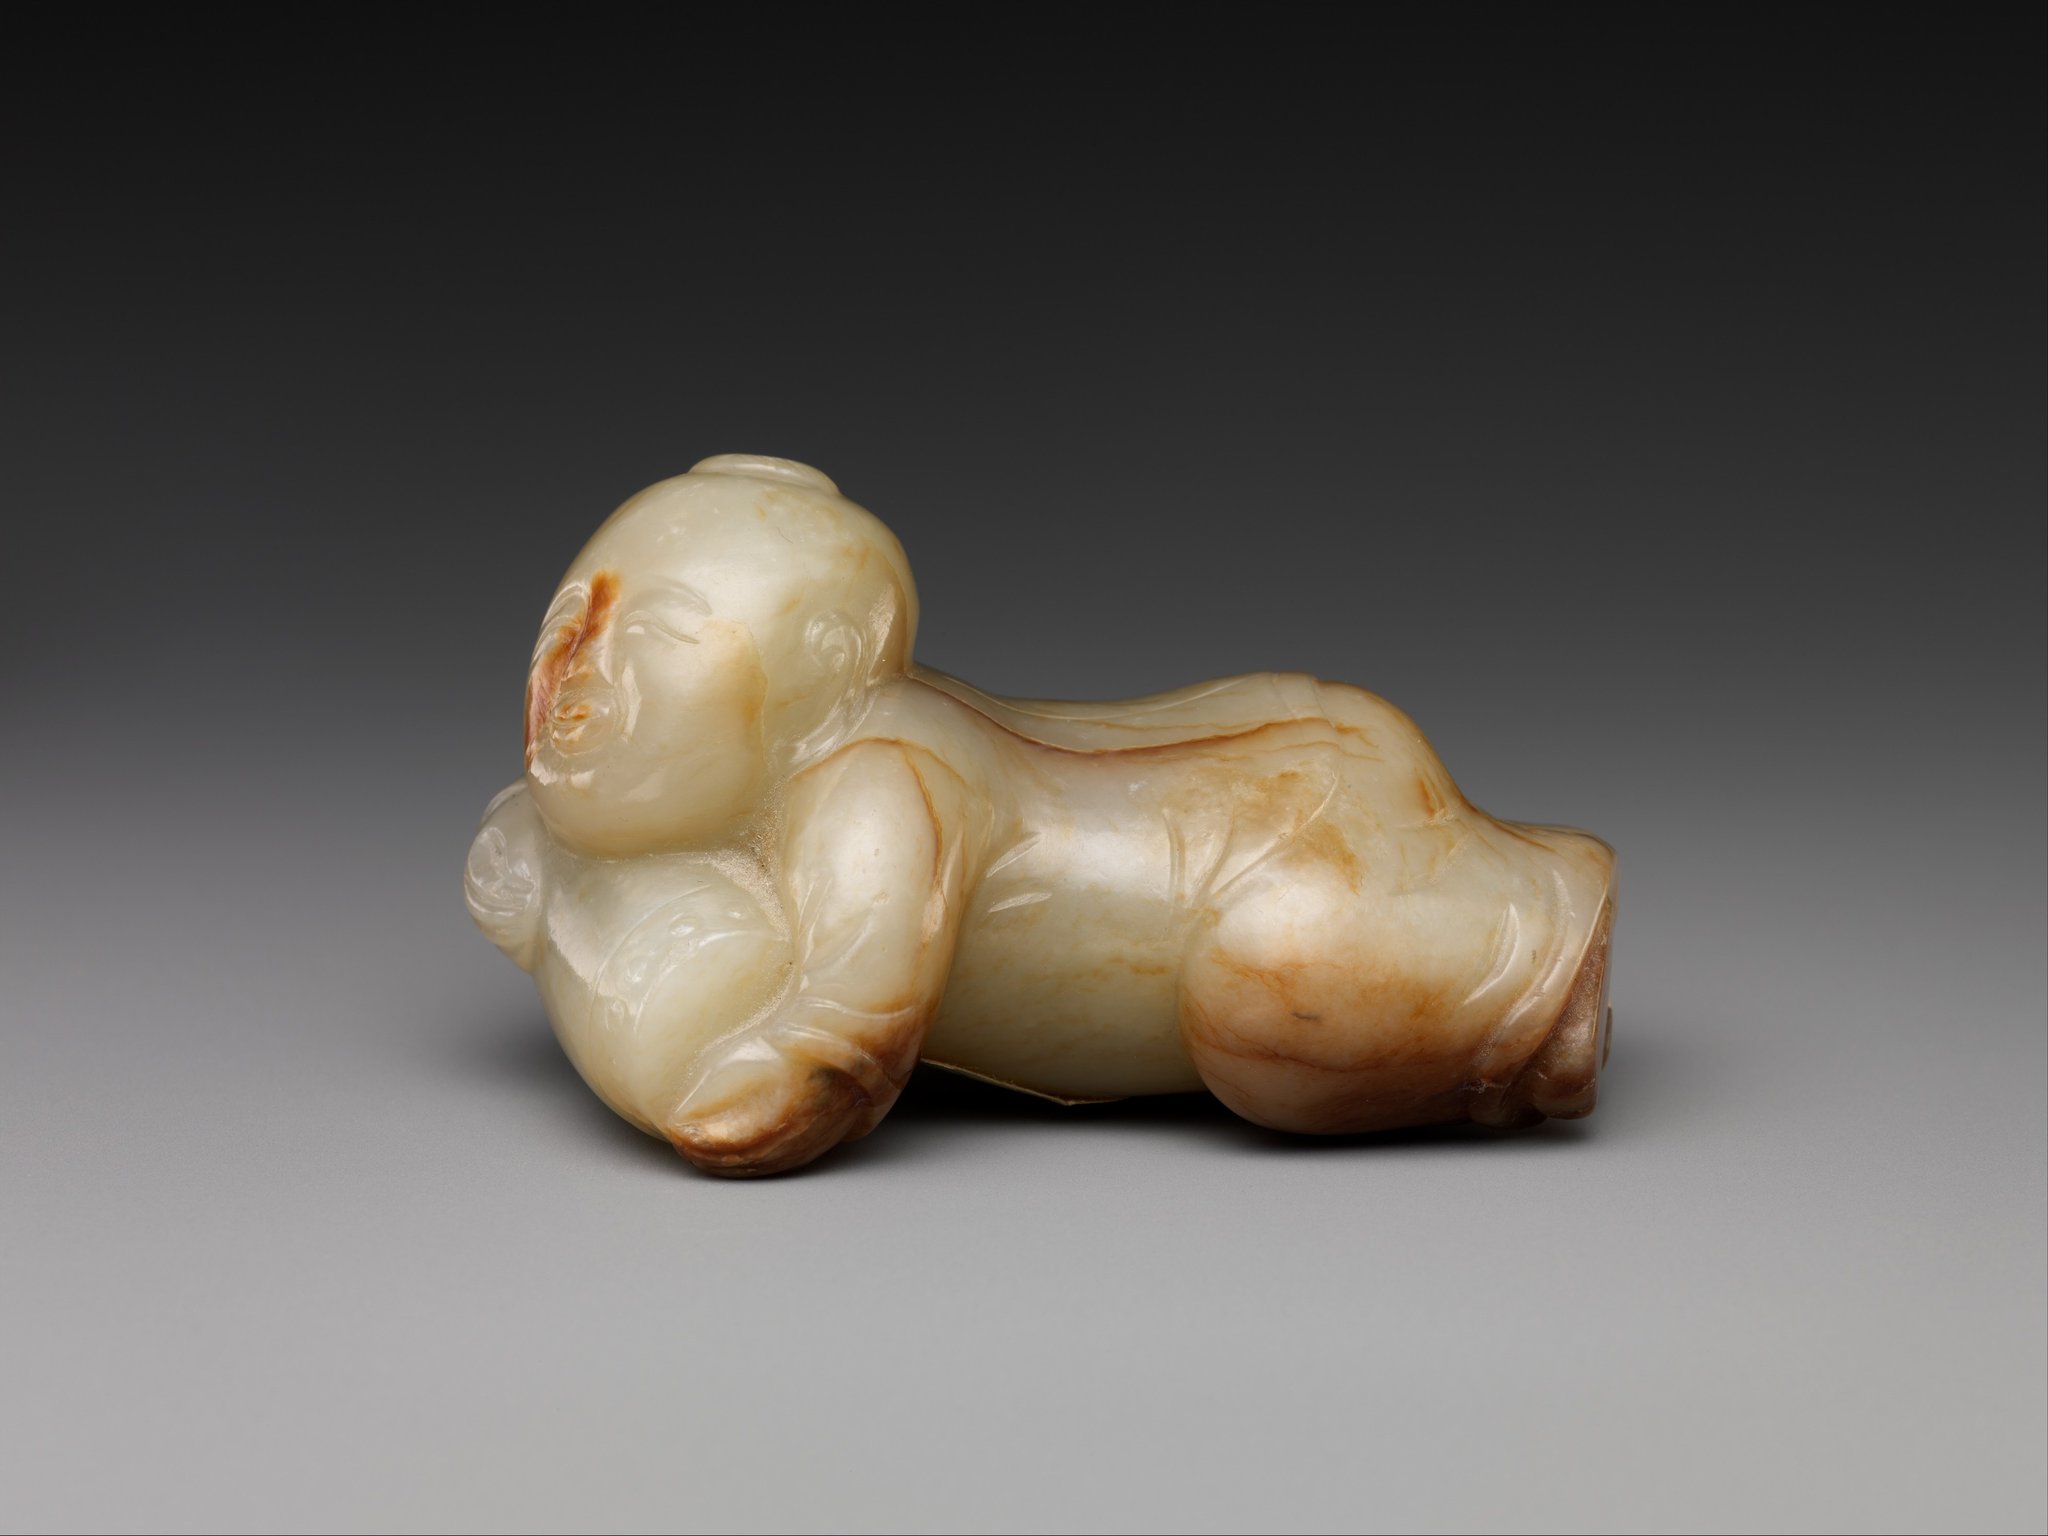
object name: figurine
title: Reclining Child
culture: chinese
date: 1501-1600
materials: jade